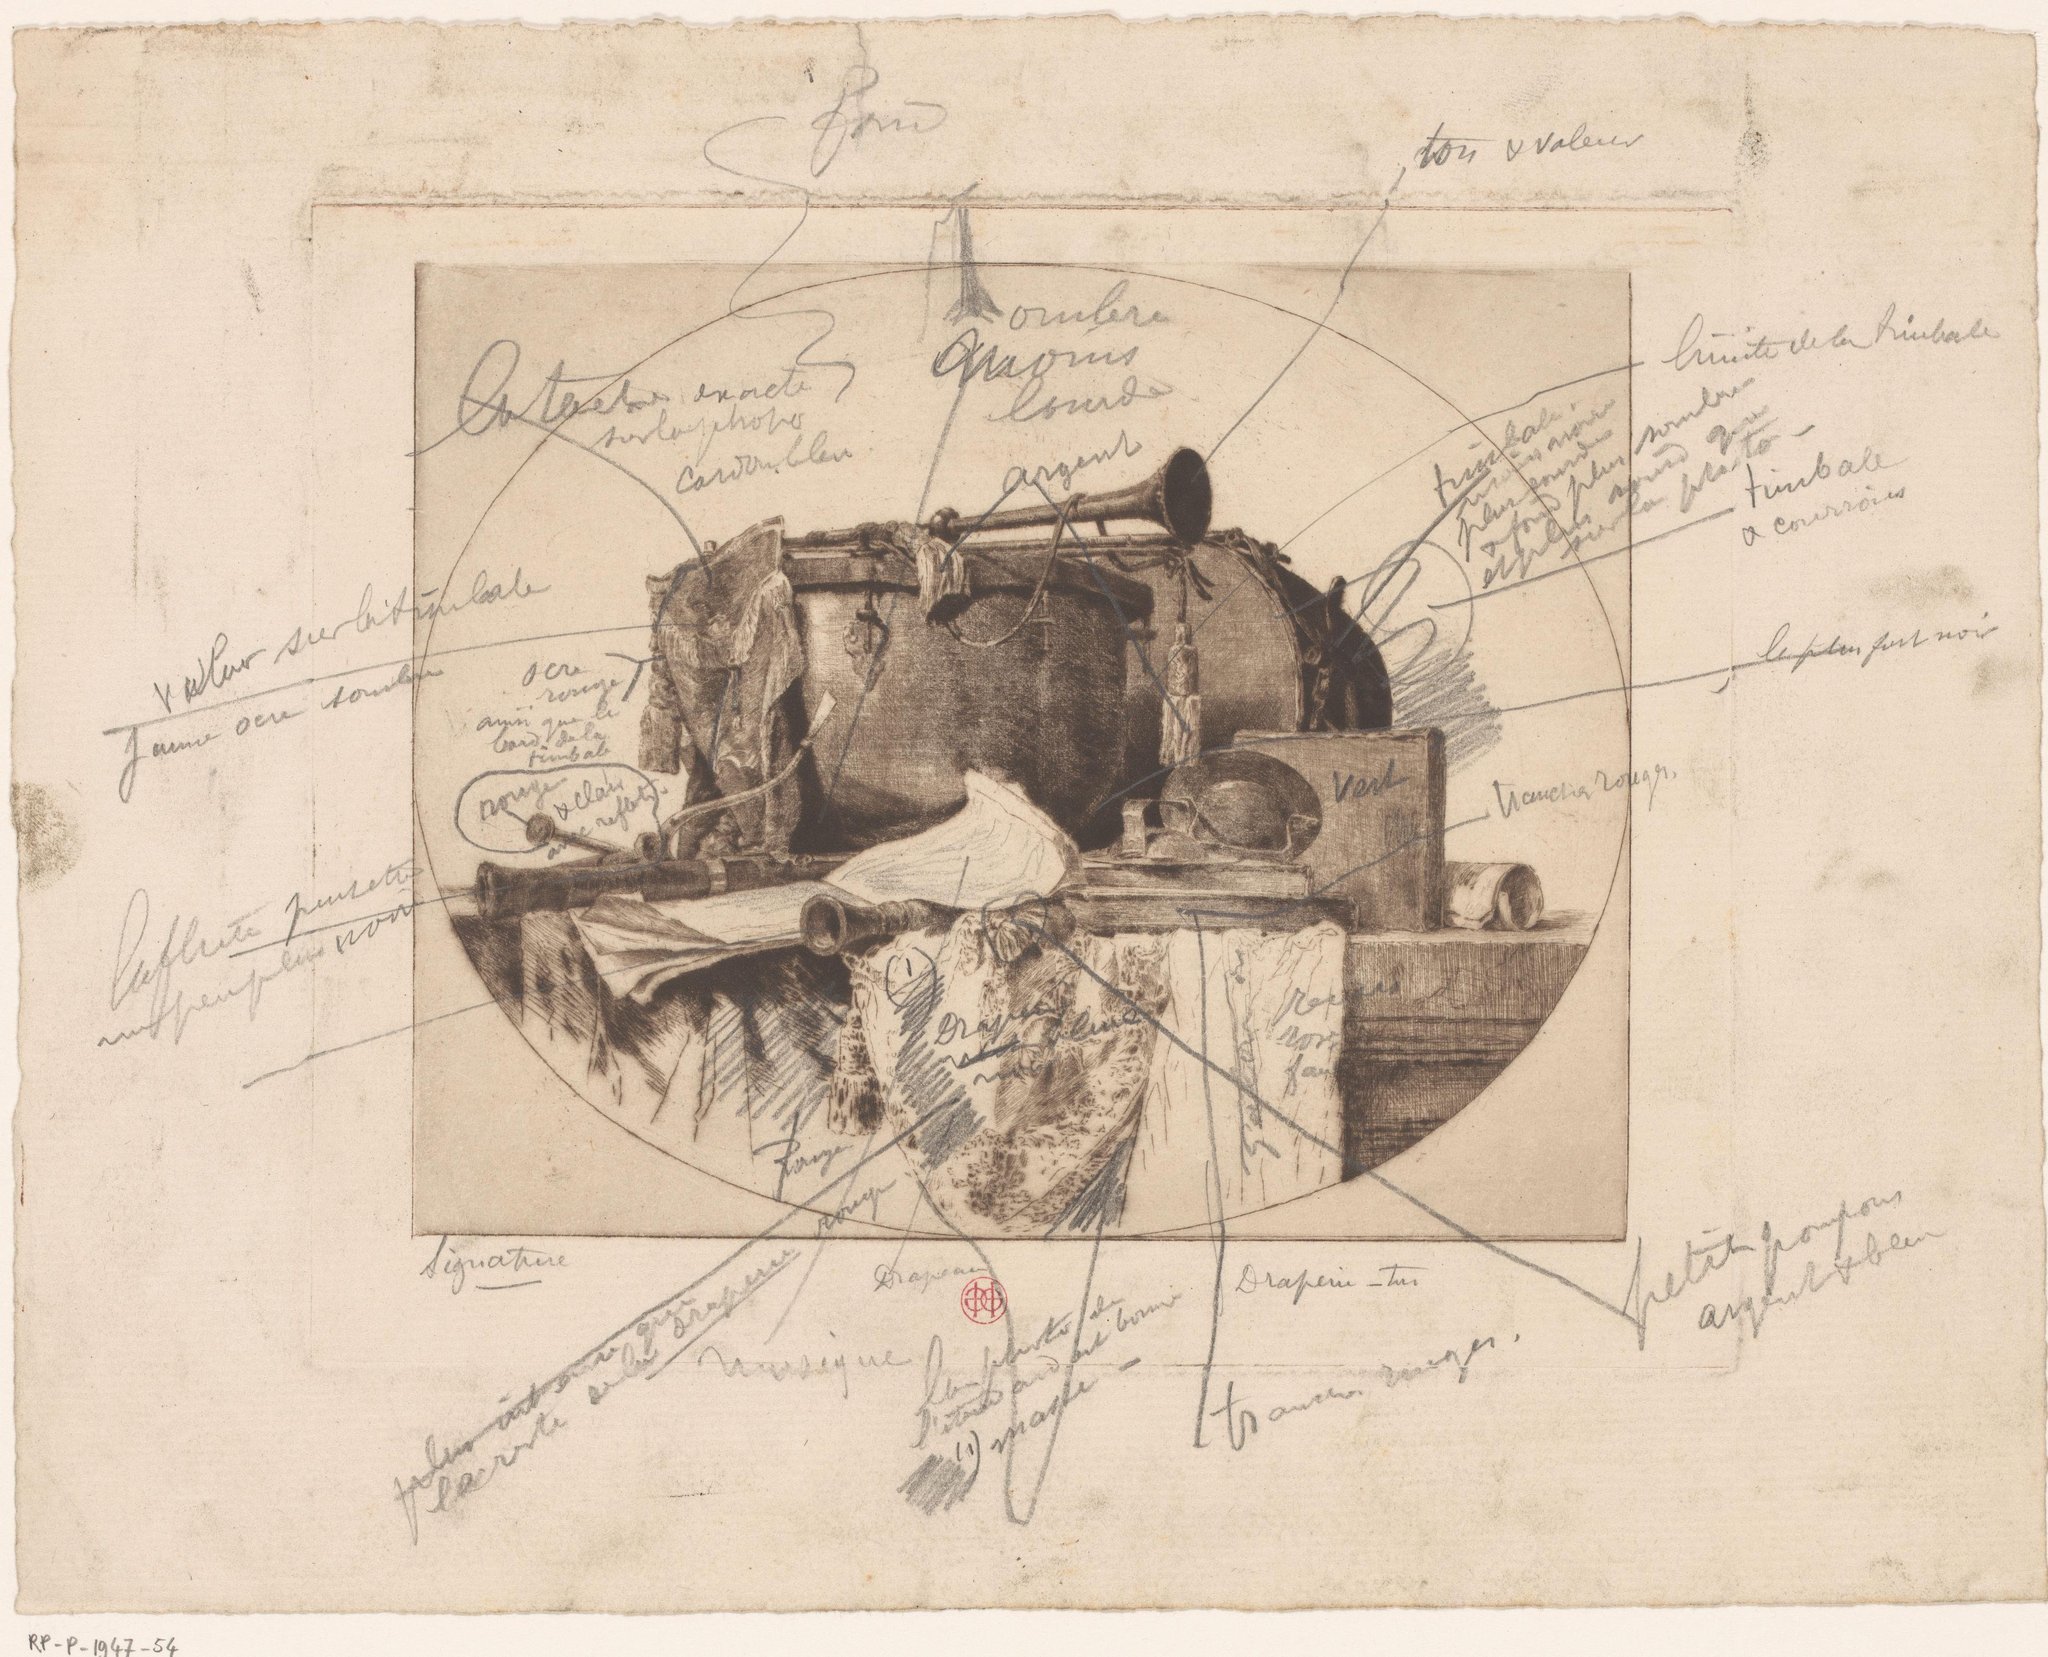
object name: print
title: Stilleven met muziekinstrumenten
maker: henri charles guérard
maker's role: print maker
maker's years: 1846-1897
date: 1890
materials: paper, pencil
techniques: etching, intaglio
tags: musical instruments; group of musical instruments, still life of related objects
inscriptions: stamp: Lugt 1157, collector's mark: Lugt 2228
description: Gepubliceerd in 'Gazette des Beaus-Arts', 1890, p. 302.